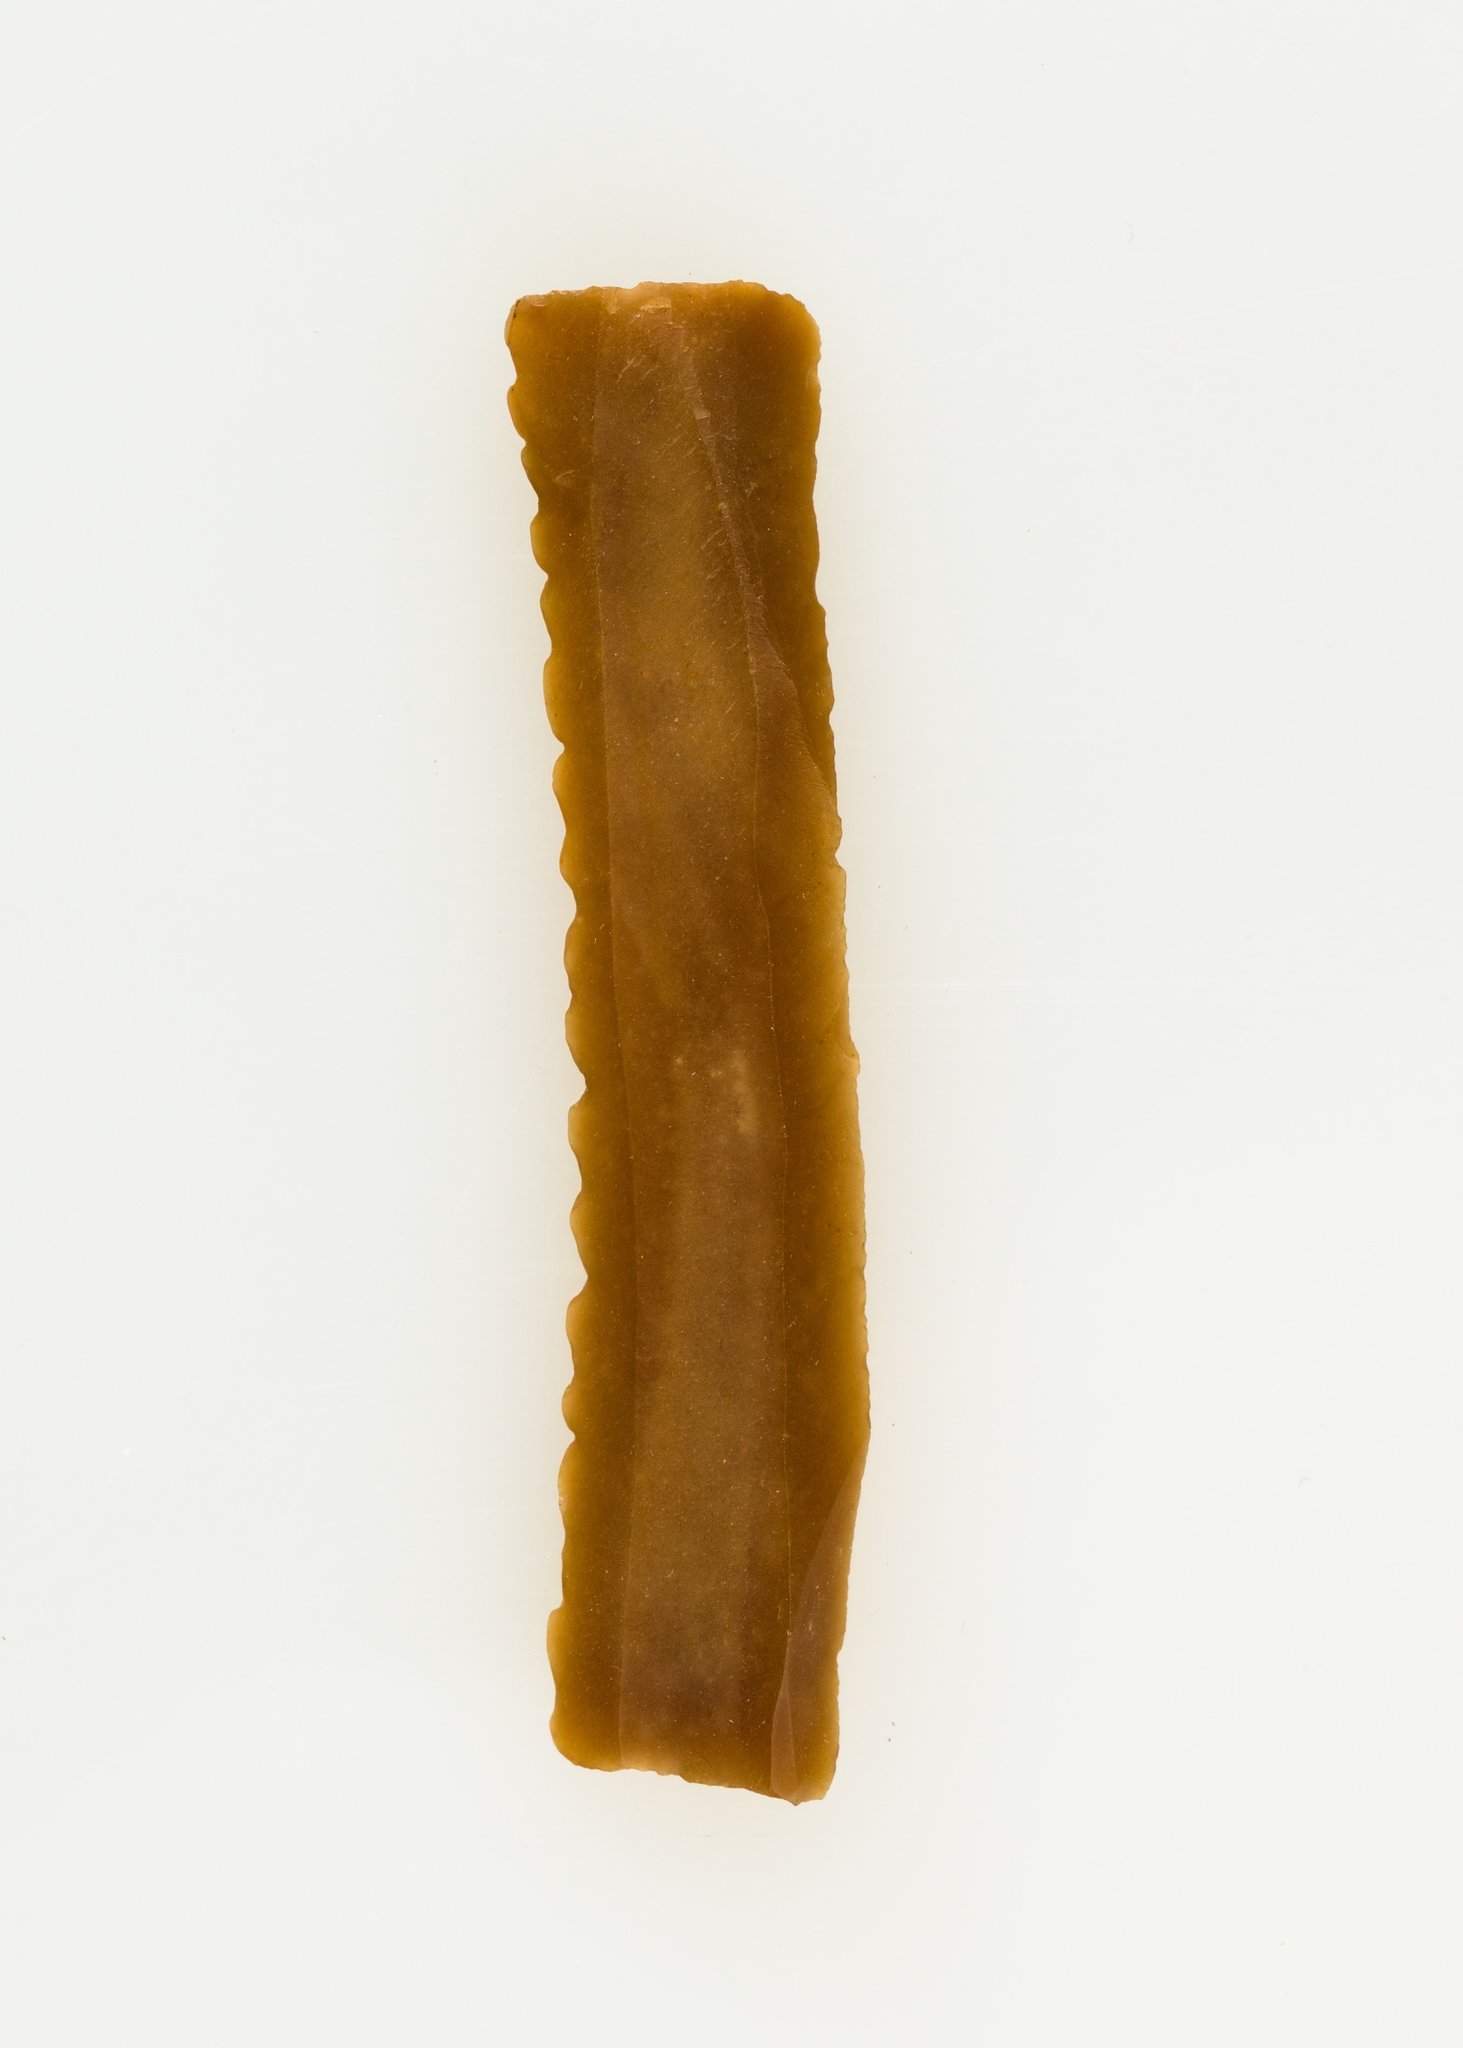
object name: sickle, insert, denticulate, backed, bi truncated, blade, tool, element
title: Sickle Insert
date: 1184-664 BCE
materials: stone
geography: egypt